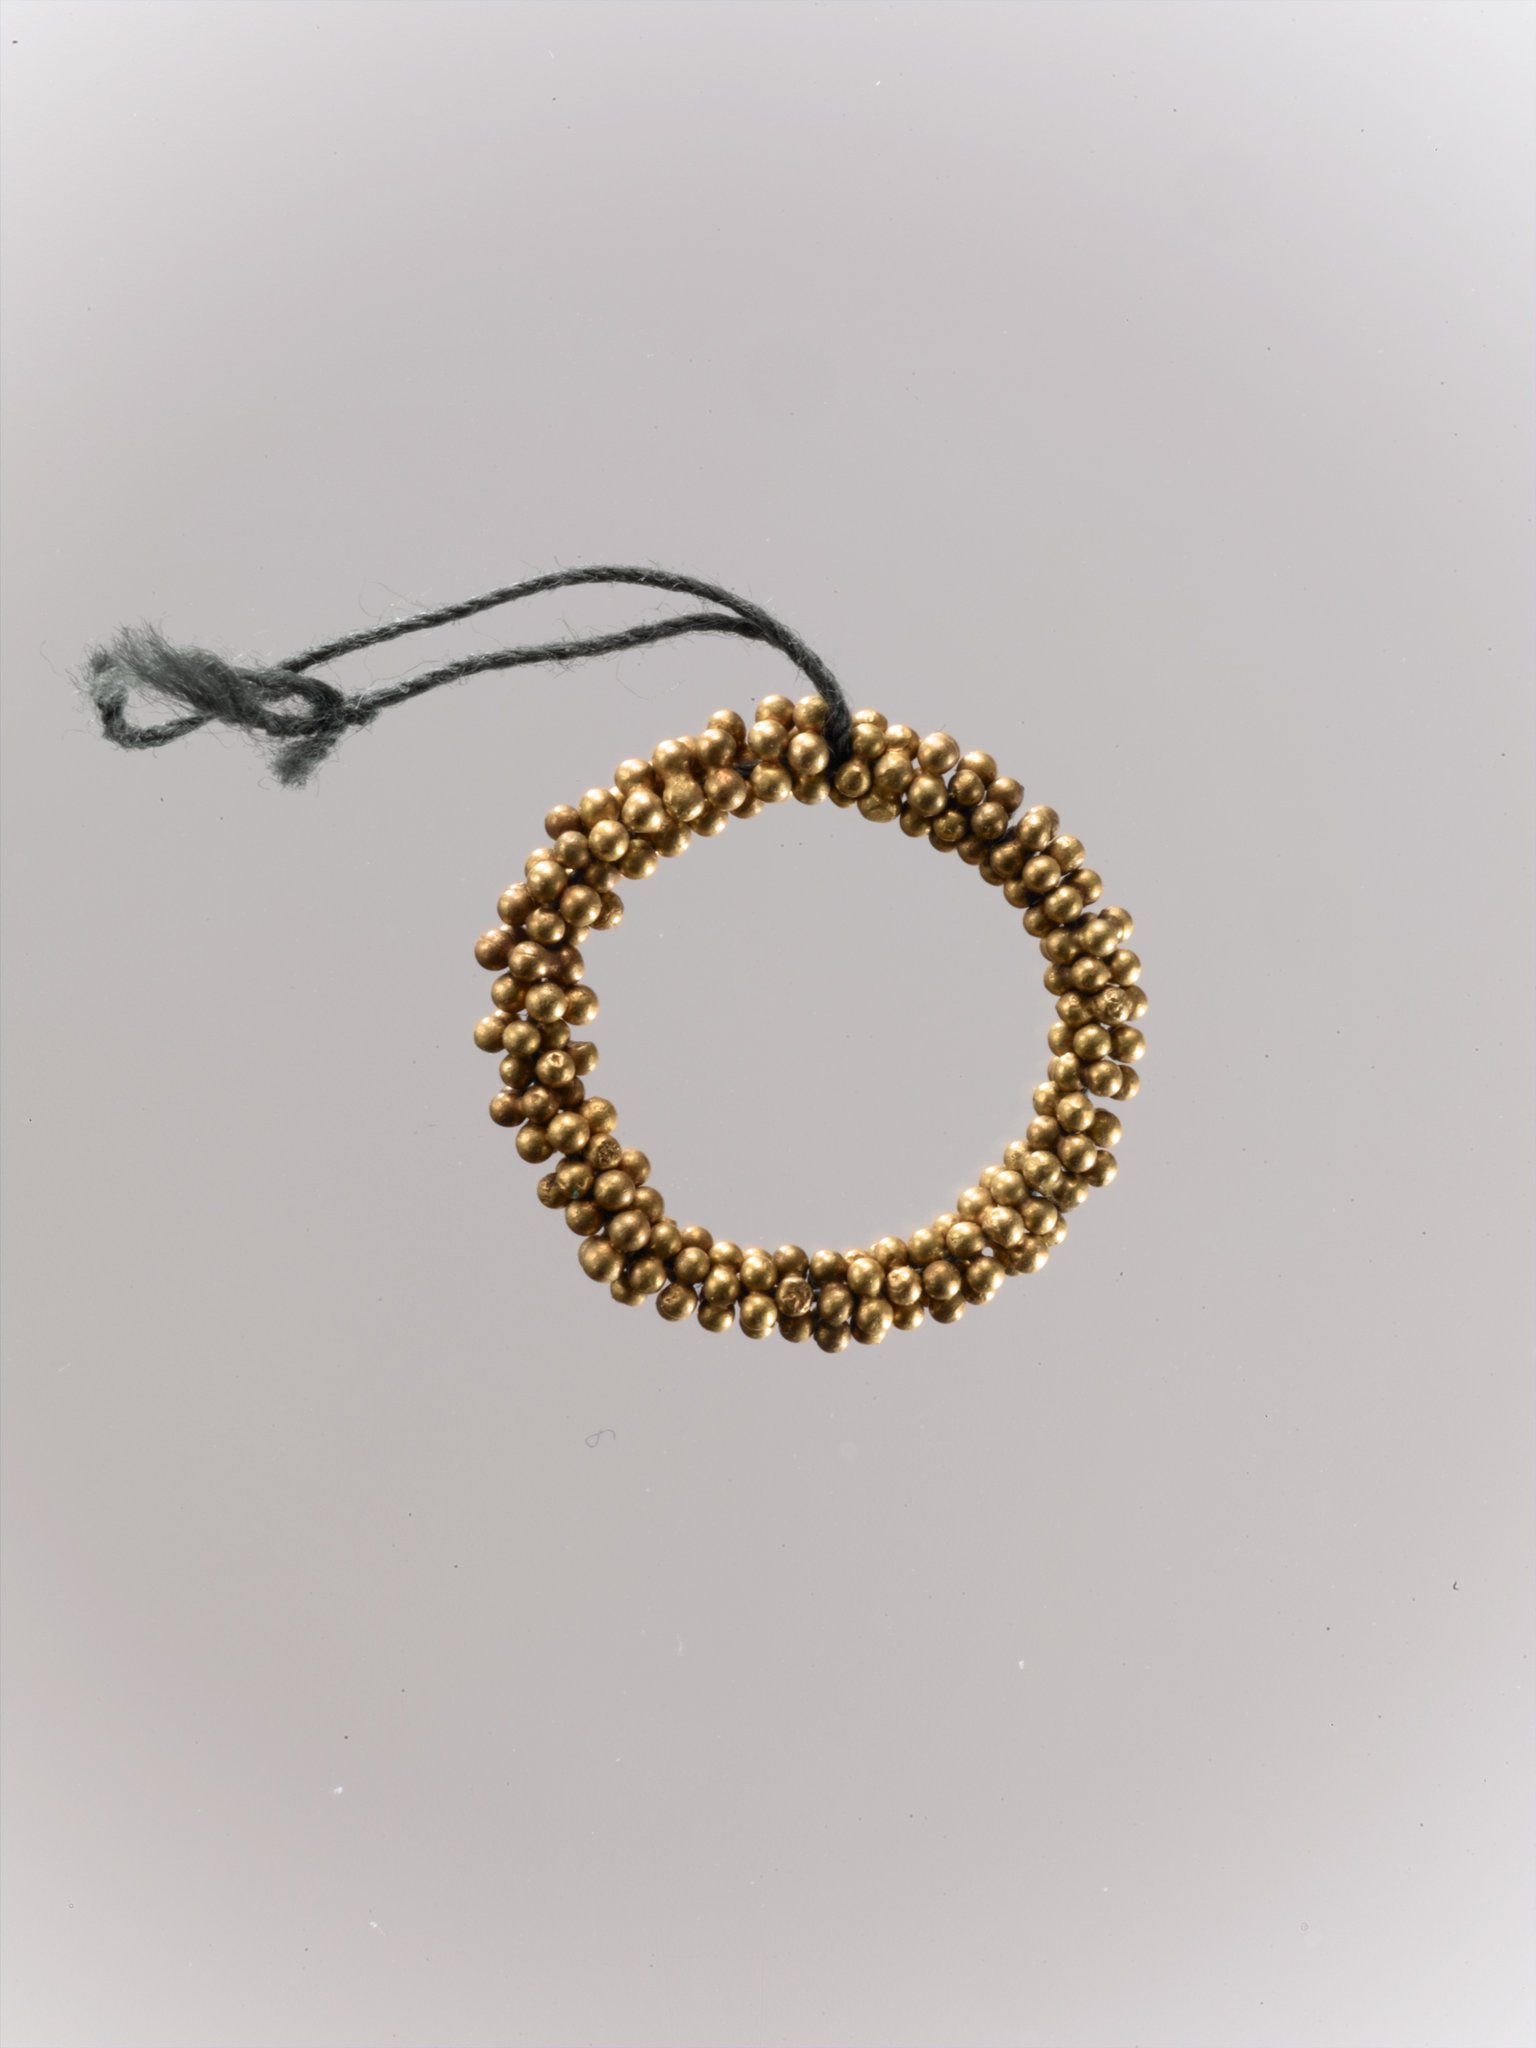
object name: bead, granulation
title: Granular beads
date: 1479-1425 BCE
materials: gold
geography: upper egypt, thebes